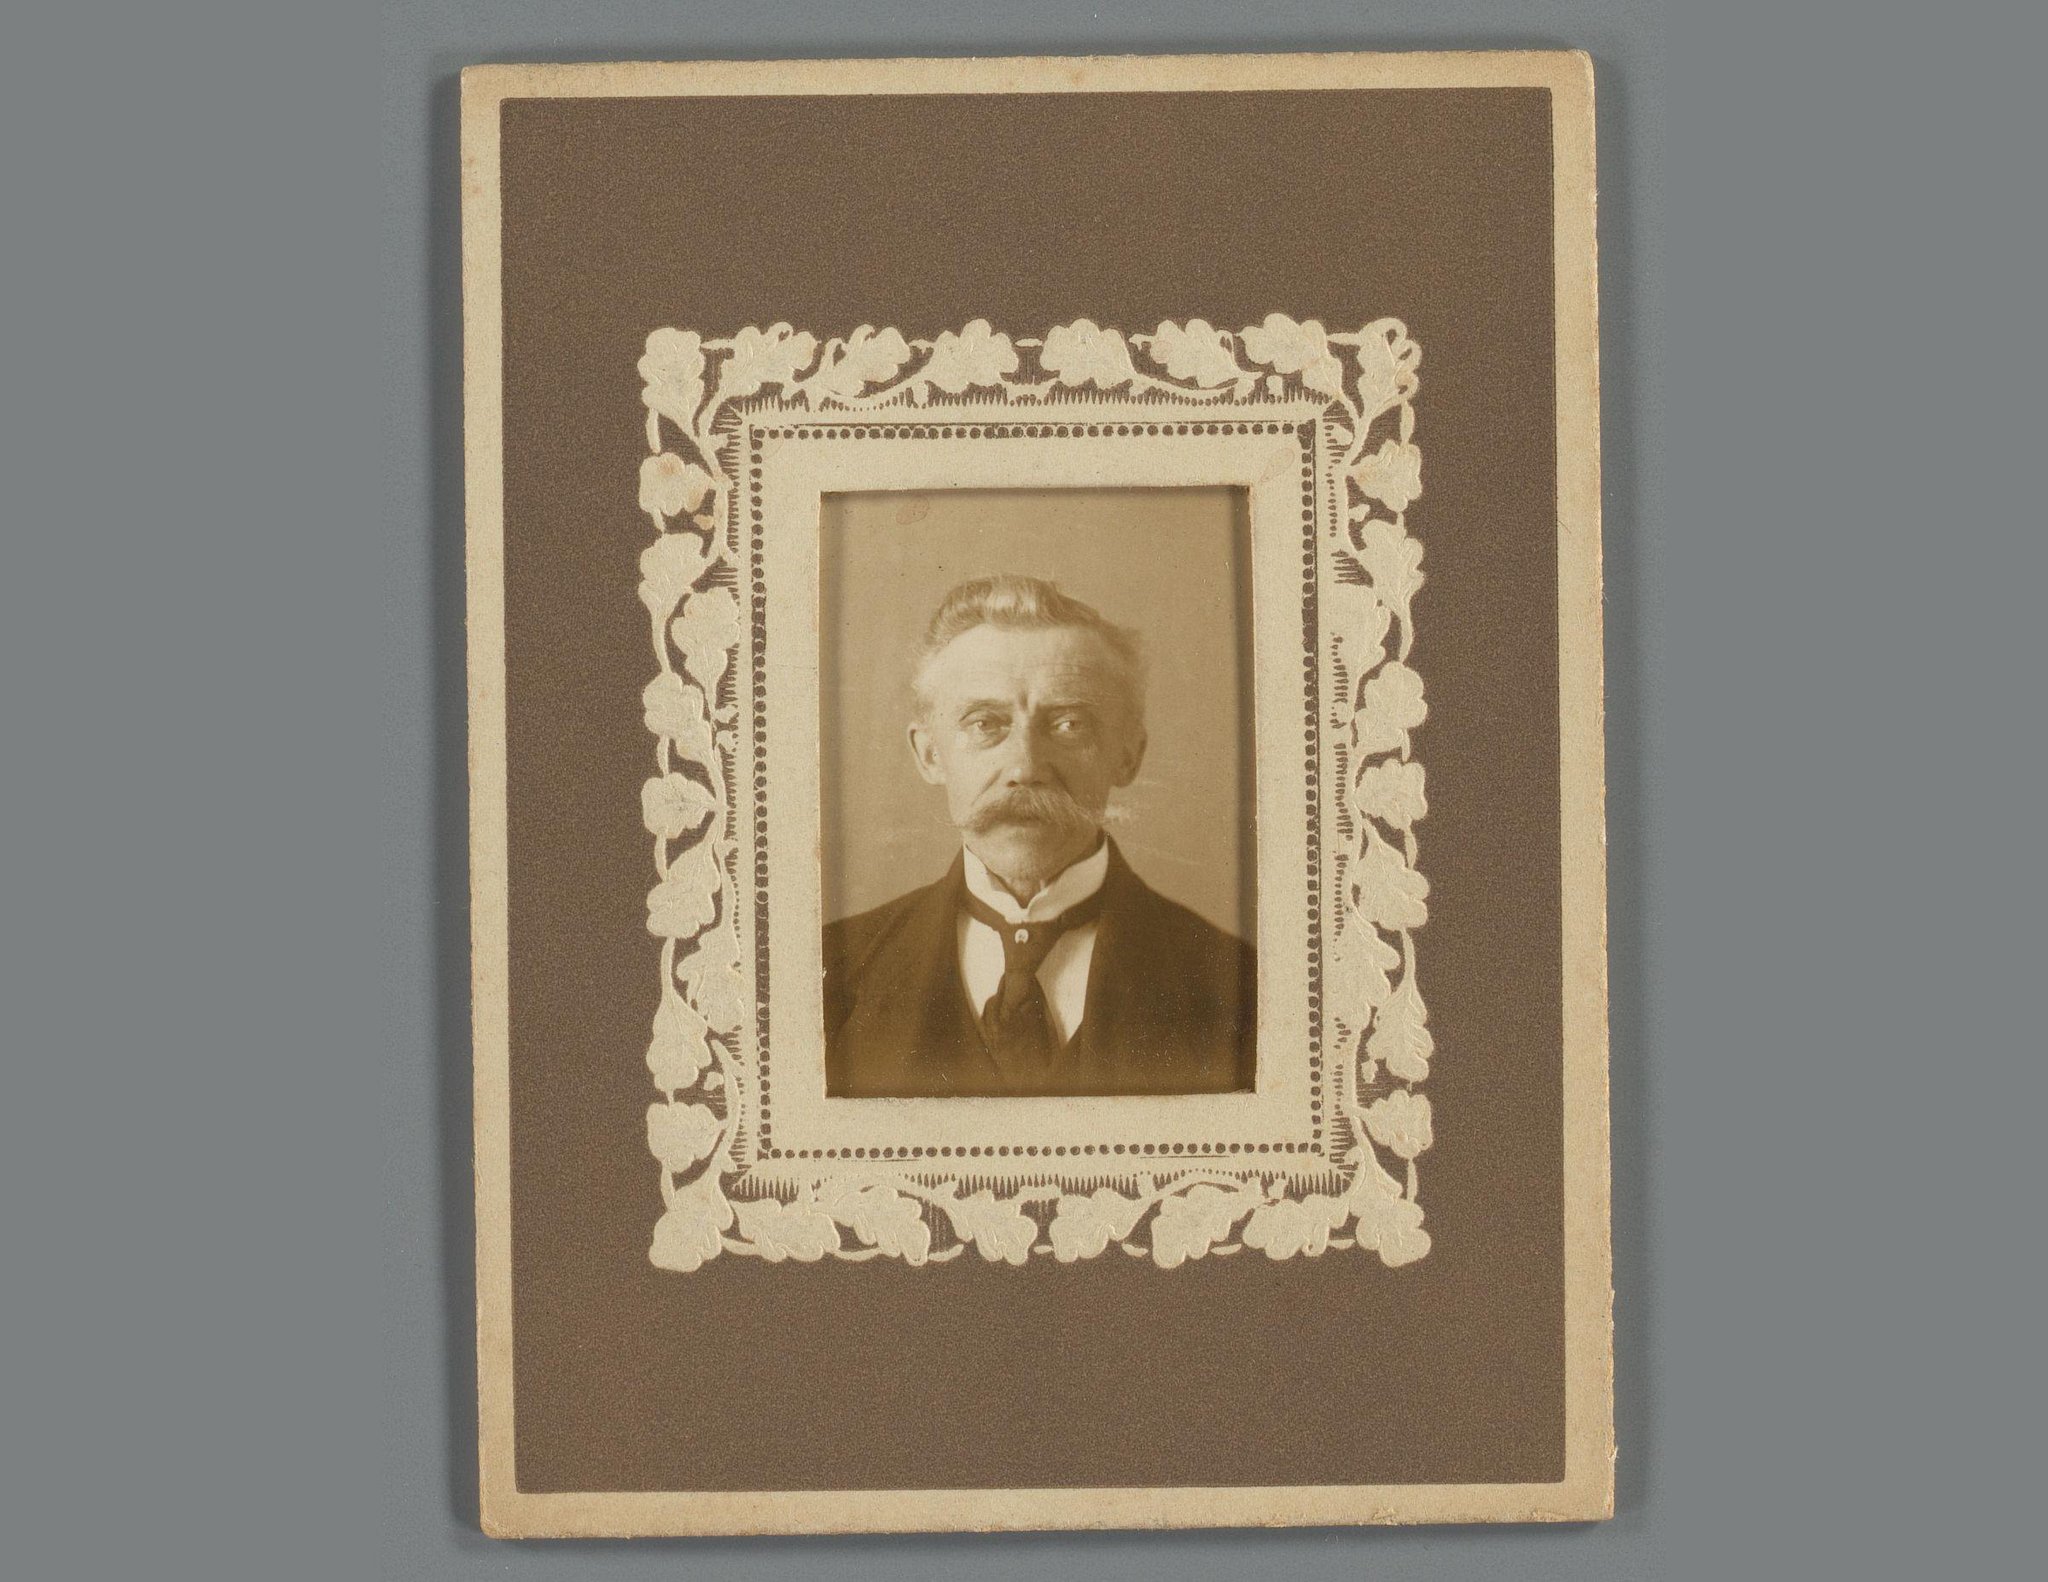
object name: snapshot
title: Portret van een onbekende oude man, gevat in een lijst van karton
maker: Anonymous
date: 1890-1920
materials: paper, cardboard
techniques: lithograph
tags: old man, anonymous historical person portrayed